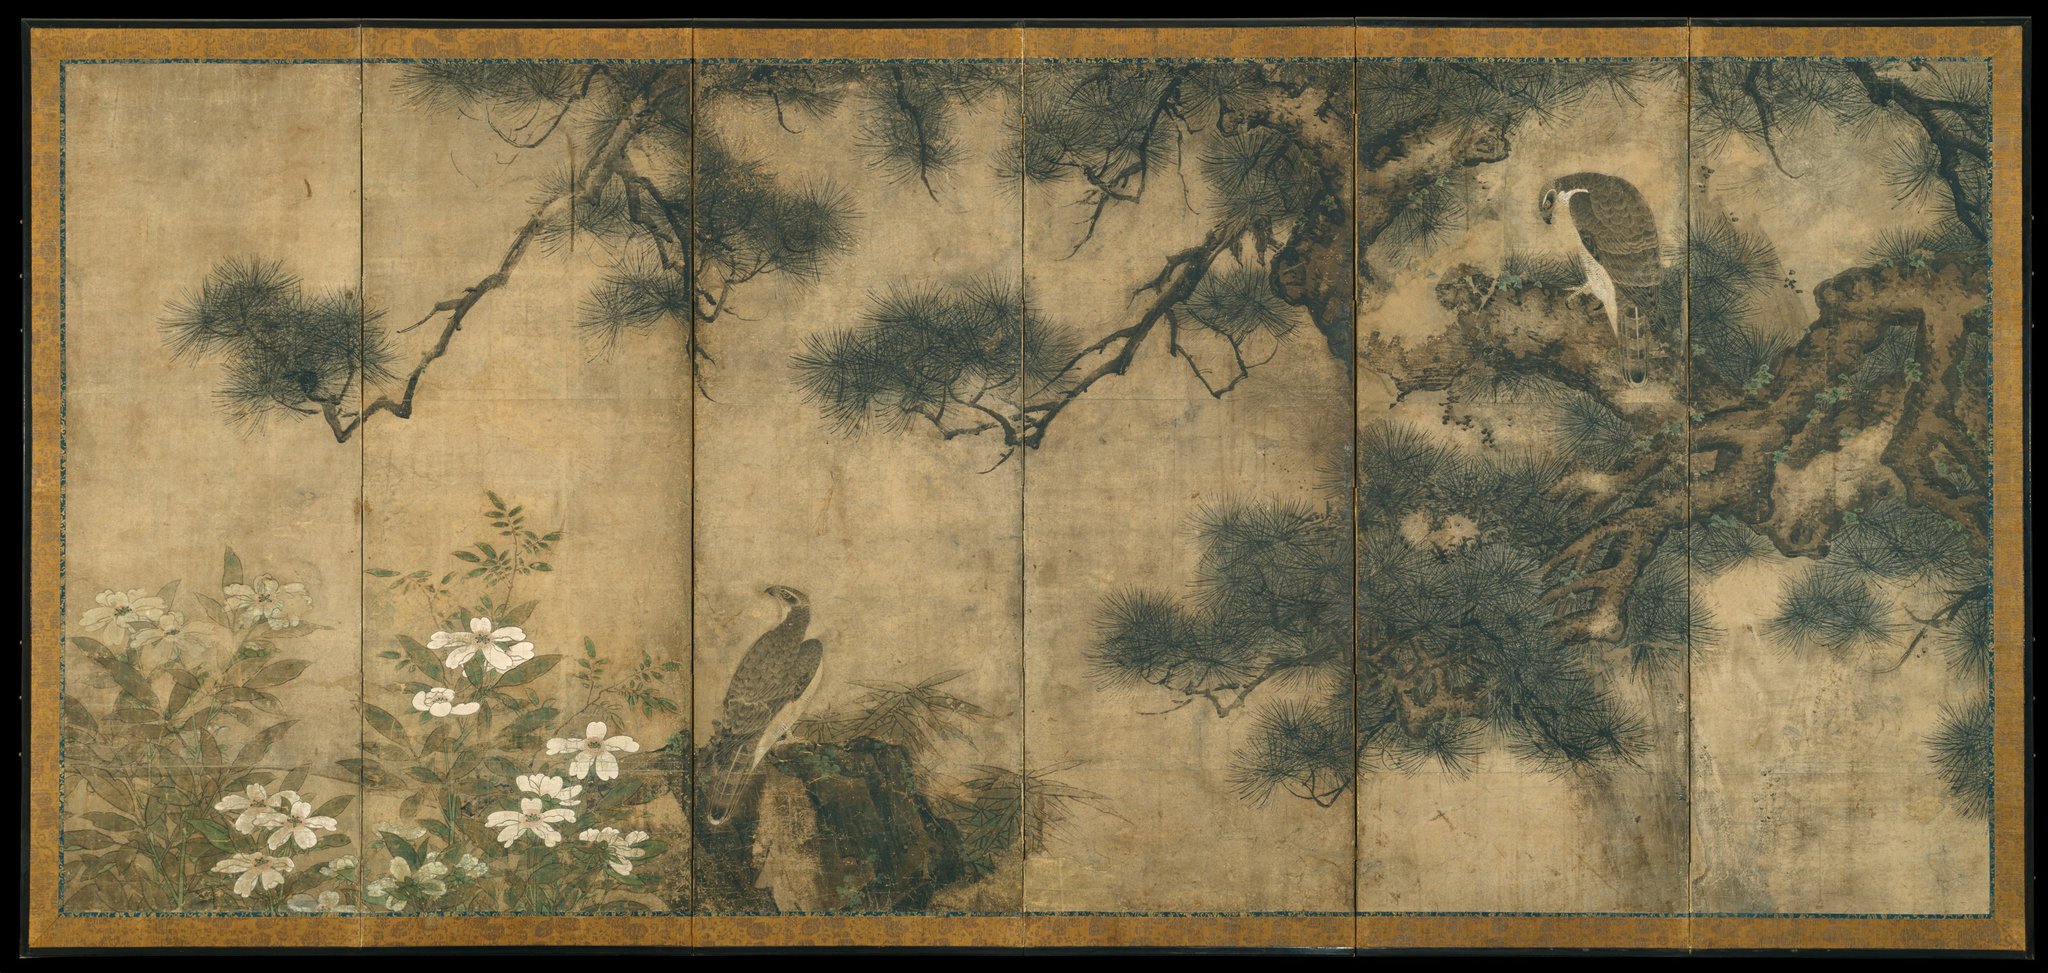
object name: screen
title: Hawks with Pine Trees and Camellias; Small Birds with Willows and Camellias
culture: japanese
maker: mitani tōshuku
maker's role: artist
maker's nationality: japanese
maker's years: 1577-1654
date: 1601-1633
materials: ink, panel, paper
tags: birds,flowers,trees